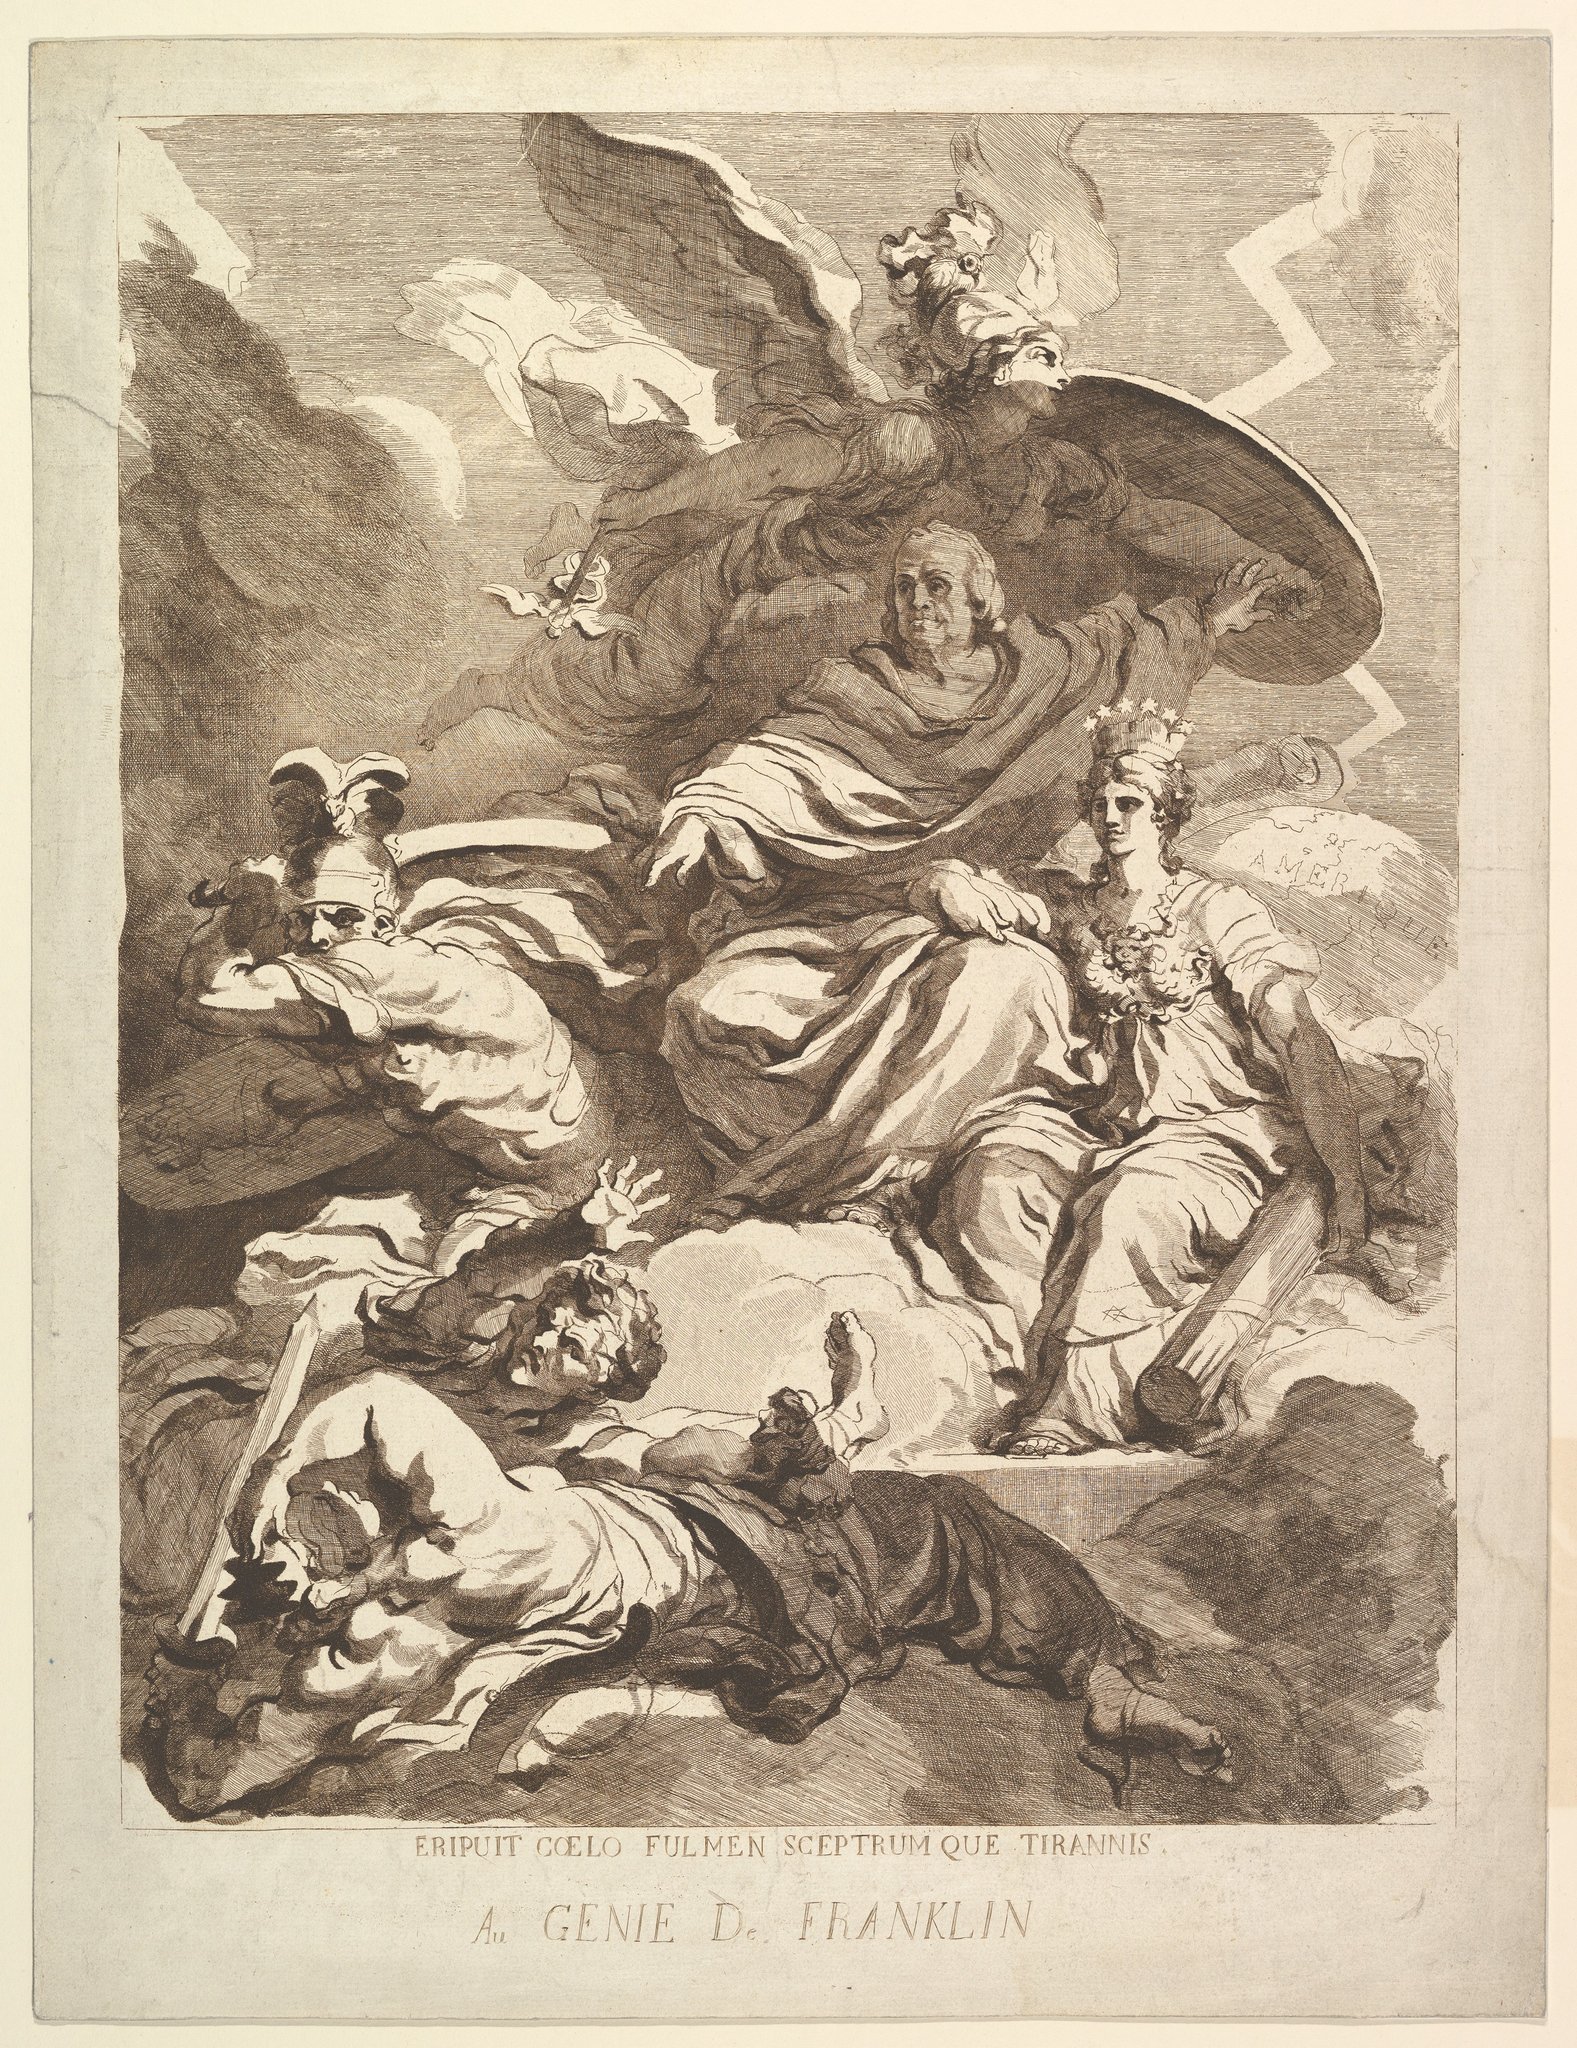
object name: print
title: To the Genius of Franklin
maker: marguerite gérard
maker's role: artist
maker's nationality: french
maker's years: 1761-1837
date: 1779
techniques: etching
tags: benjamin franklin,men,women